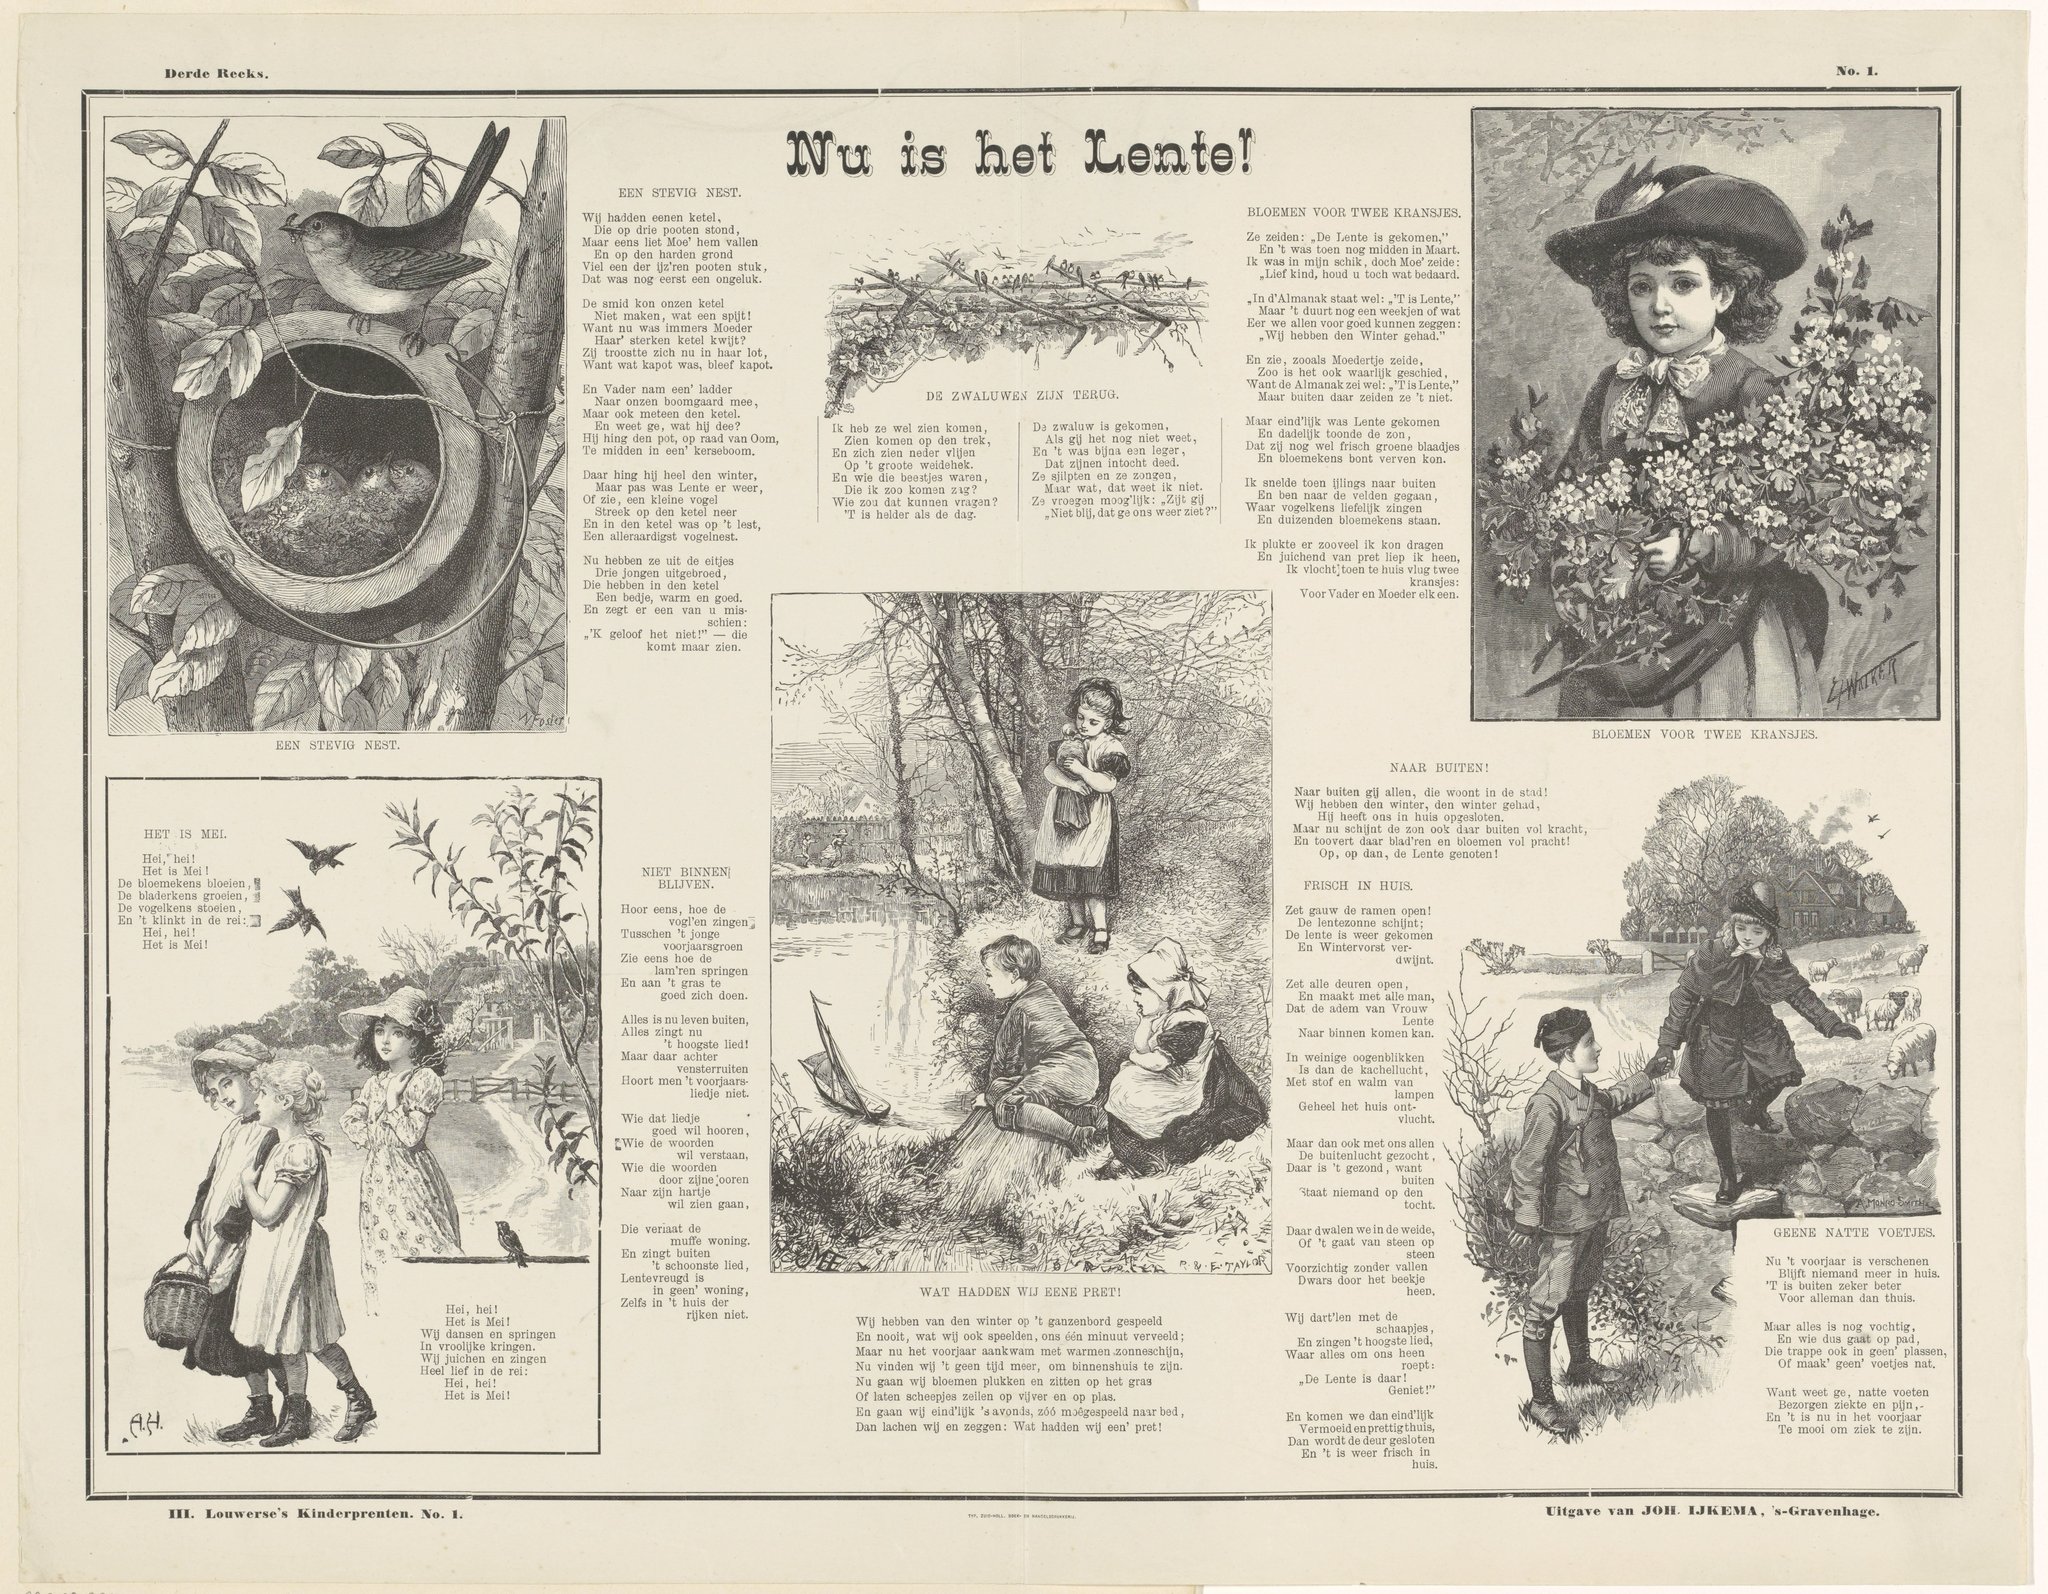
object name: popular print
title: Derde reeks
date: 1892-1905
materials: paper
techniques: letterpress printing, printing block, engraving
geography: the hague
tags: children's games and plays, spring ~ human activities (the four seasons of the year), plants; vegetation (+ flowers, blossom, blossoming), birds (+ animals nesting; making nests, lodges, webs, etc.)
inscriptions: collector's mark: Lugt 2760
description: Blad met 6 voorstellingen van lentetaferelen, zoals een nestje jonge vogels, zwaluwen, een meisje met bloesemtakken, en kinderen die buiten spelen. Tussen de afbeeldingen versjes in boekdruk. Genummerd rechtsboven en linksonder: No. 1.